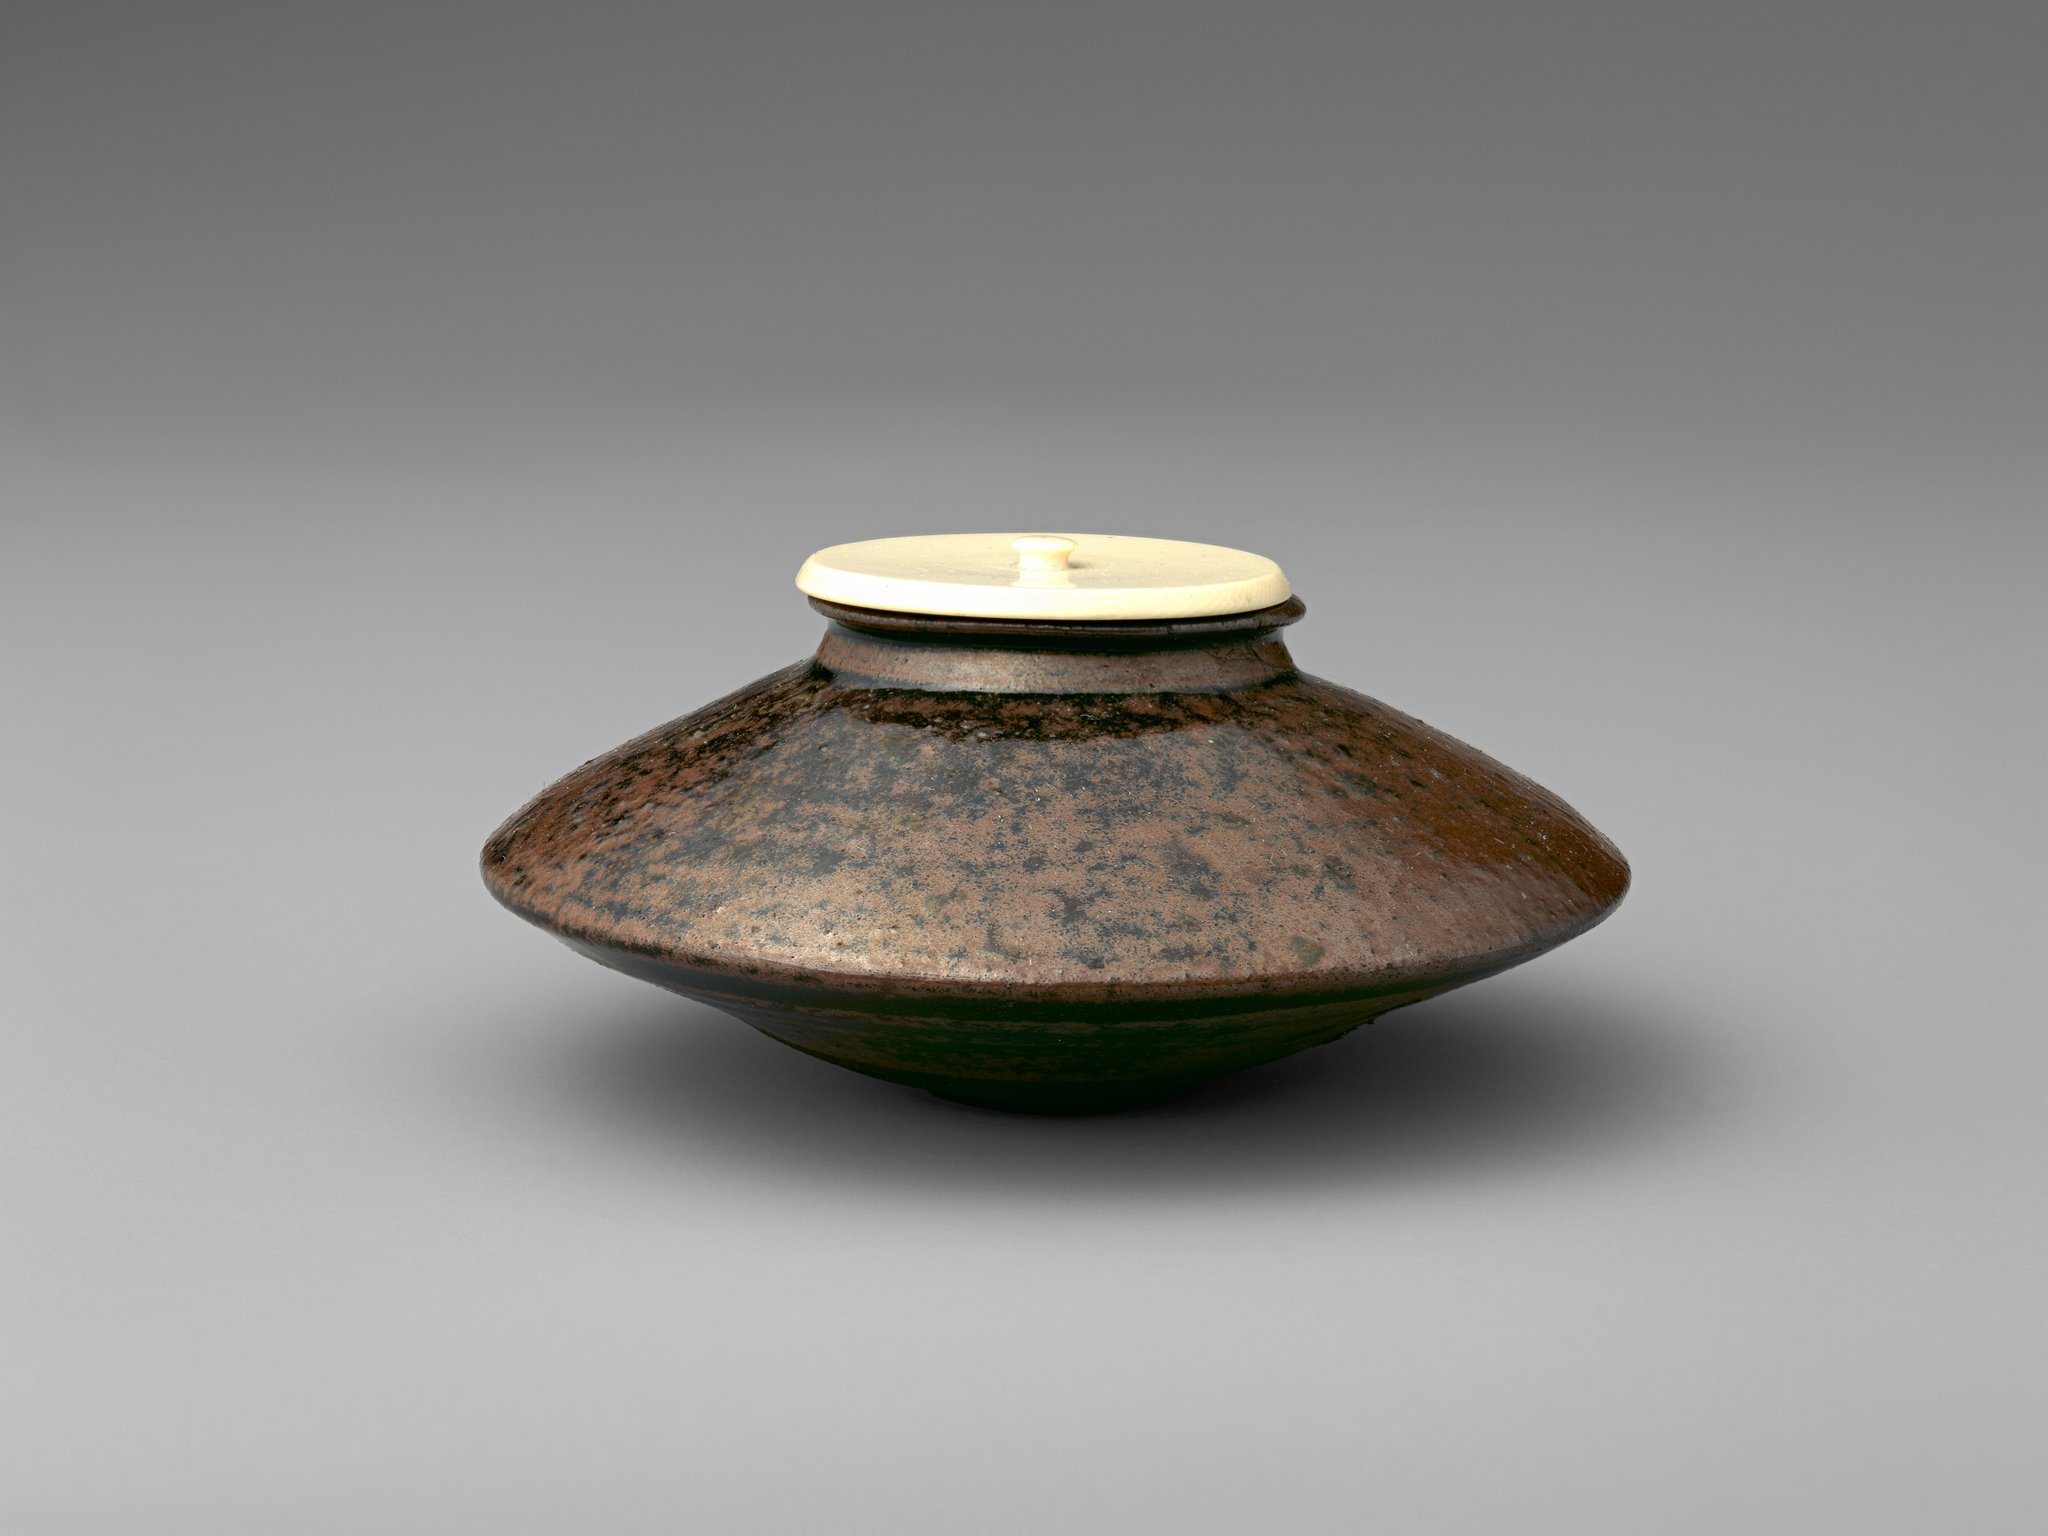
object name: tea caddy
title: Tea Caddy (Chaire)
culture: japanese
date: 1701-1800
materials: glaze, iron, ivory, stoneware